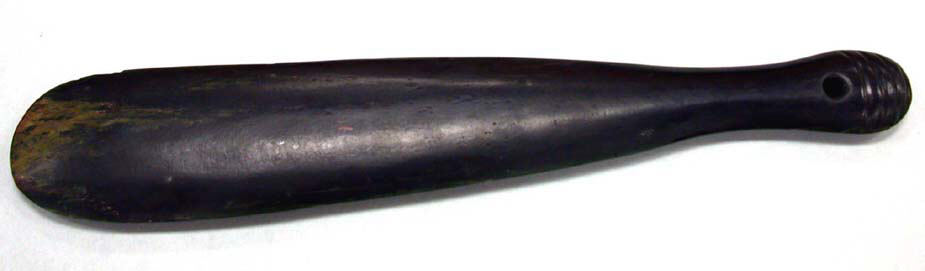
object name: warclub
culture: new zealander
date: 1902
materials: jade